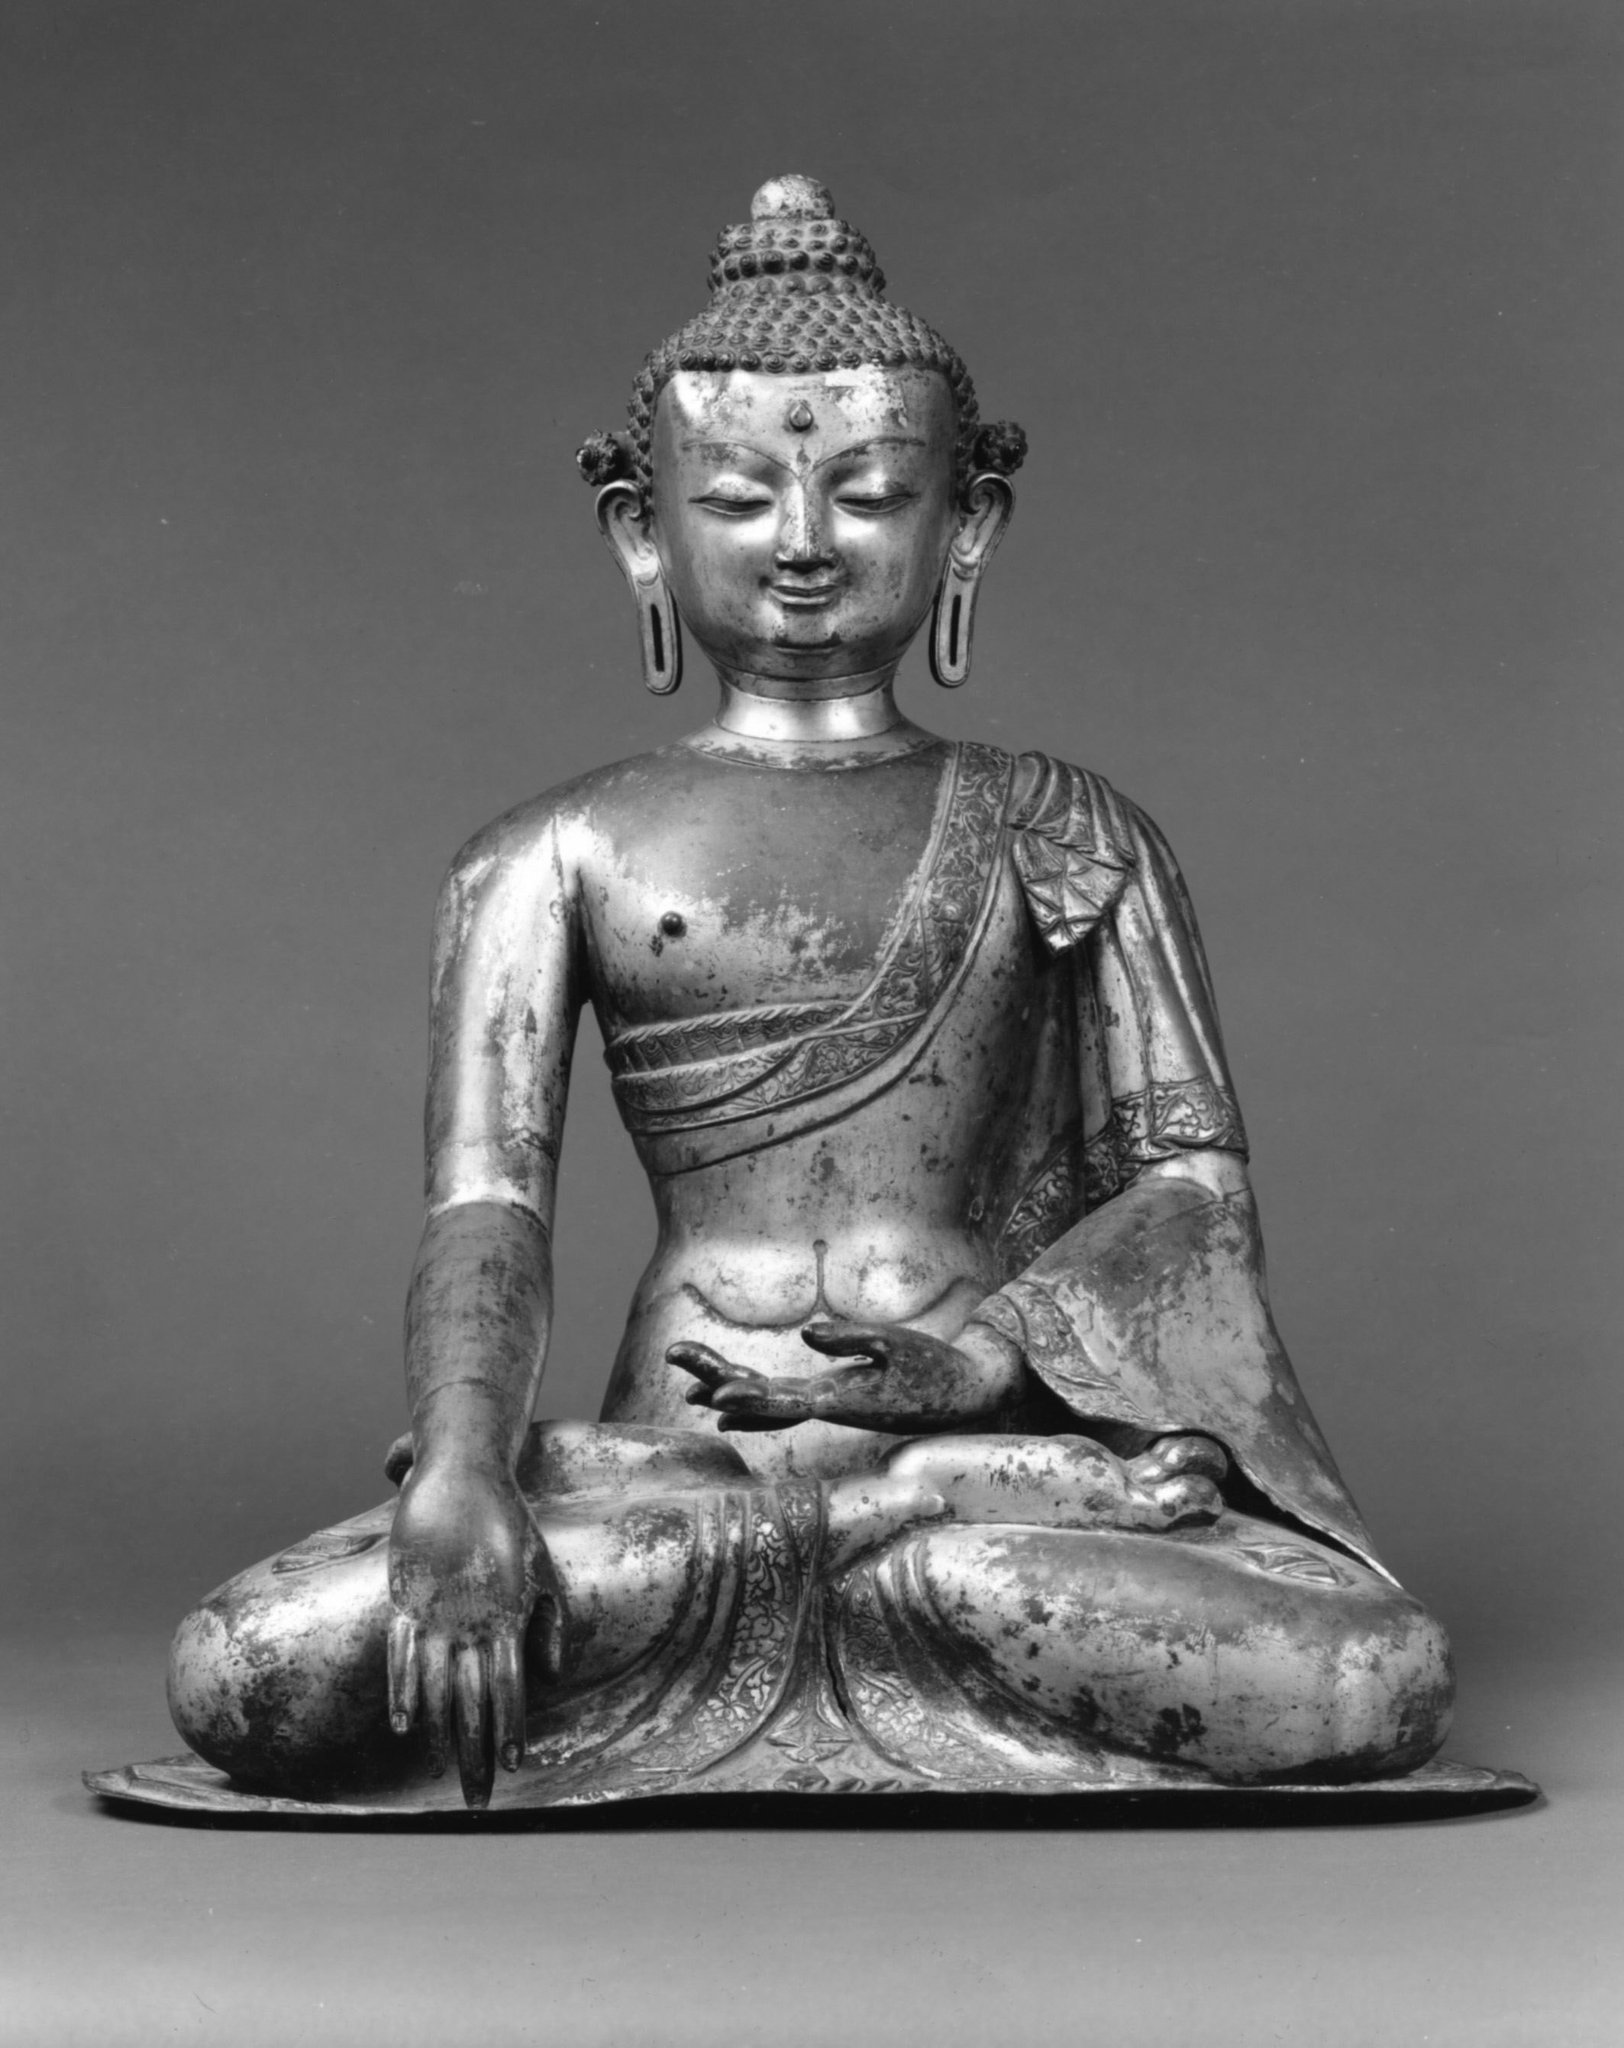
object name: figure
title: Seated Buddha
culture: nepali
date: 1301-1500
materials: copper, stone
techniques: inlay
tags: buddha